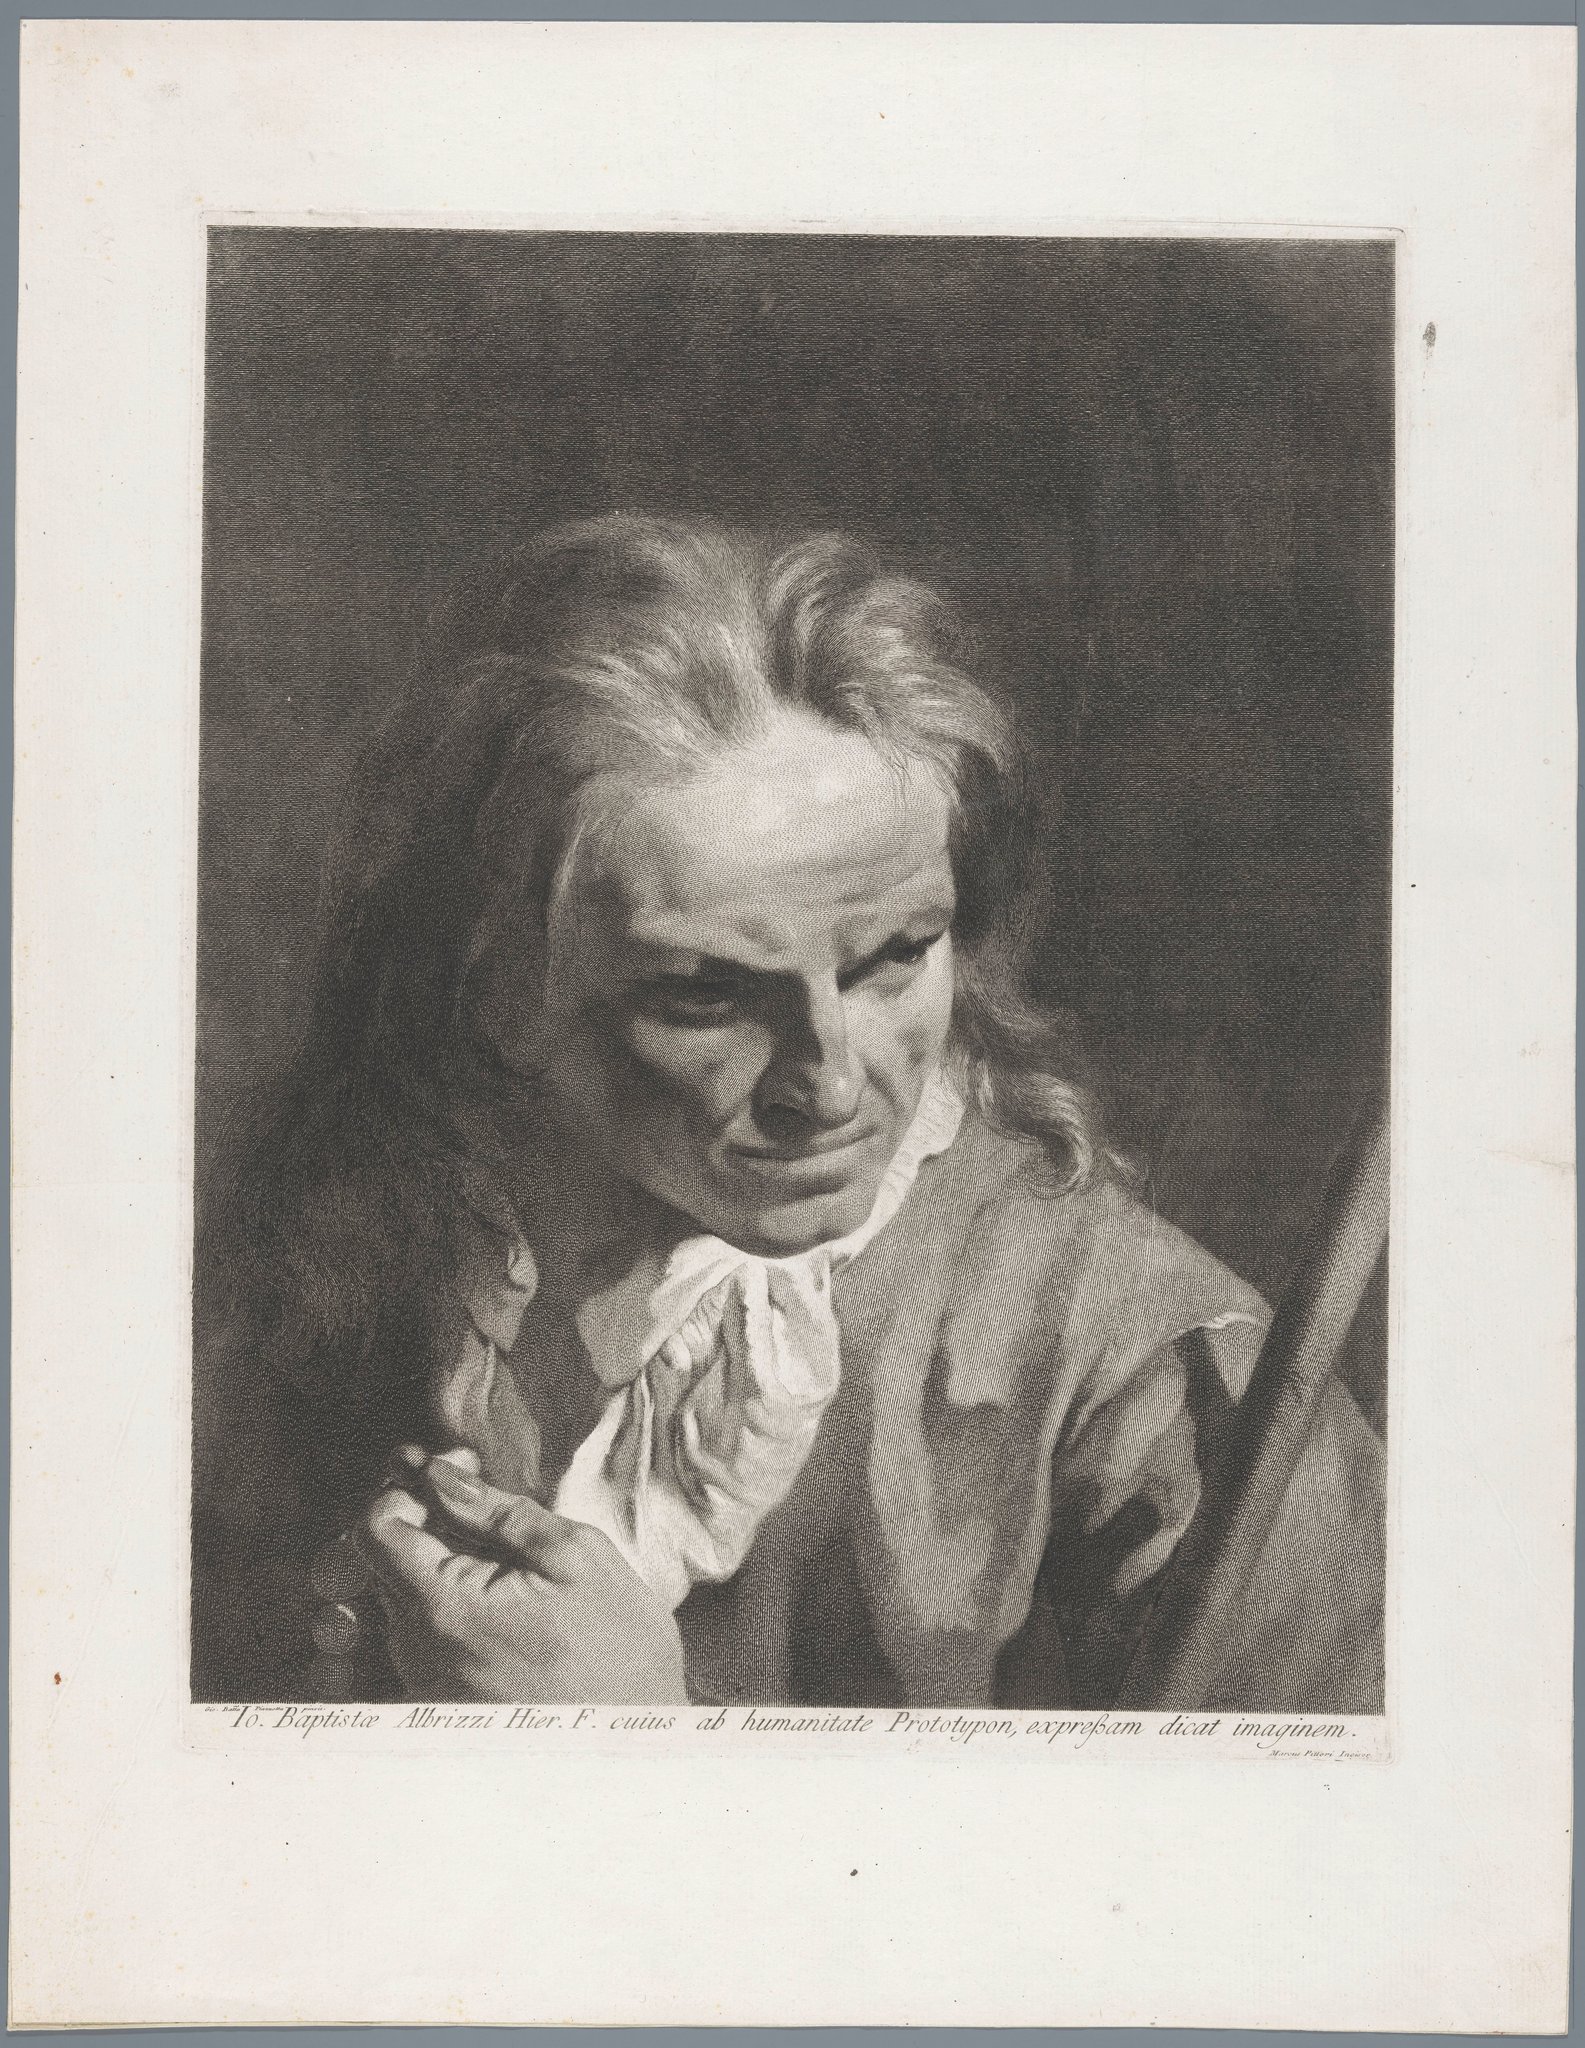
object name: print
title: Man met rozenkrans en stok, mogelijk Giambatista Albrizzi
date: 1712-1786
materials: paper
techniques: engraving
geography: venice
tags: giambattista albrizzi, anonymous historical person portrayed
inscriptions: collector's mark: Lugt 240